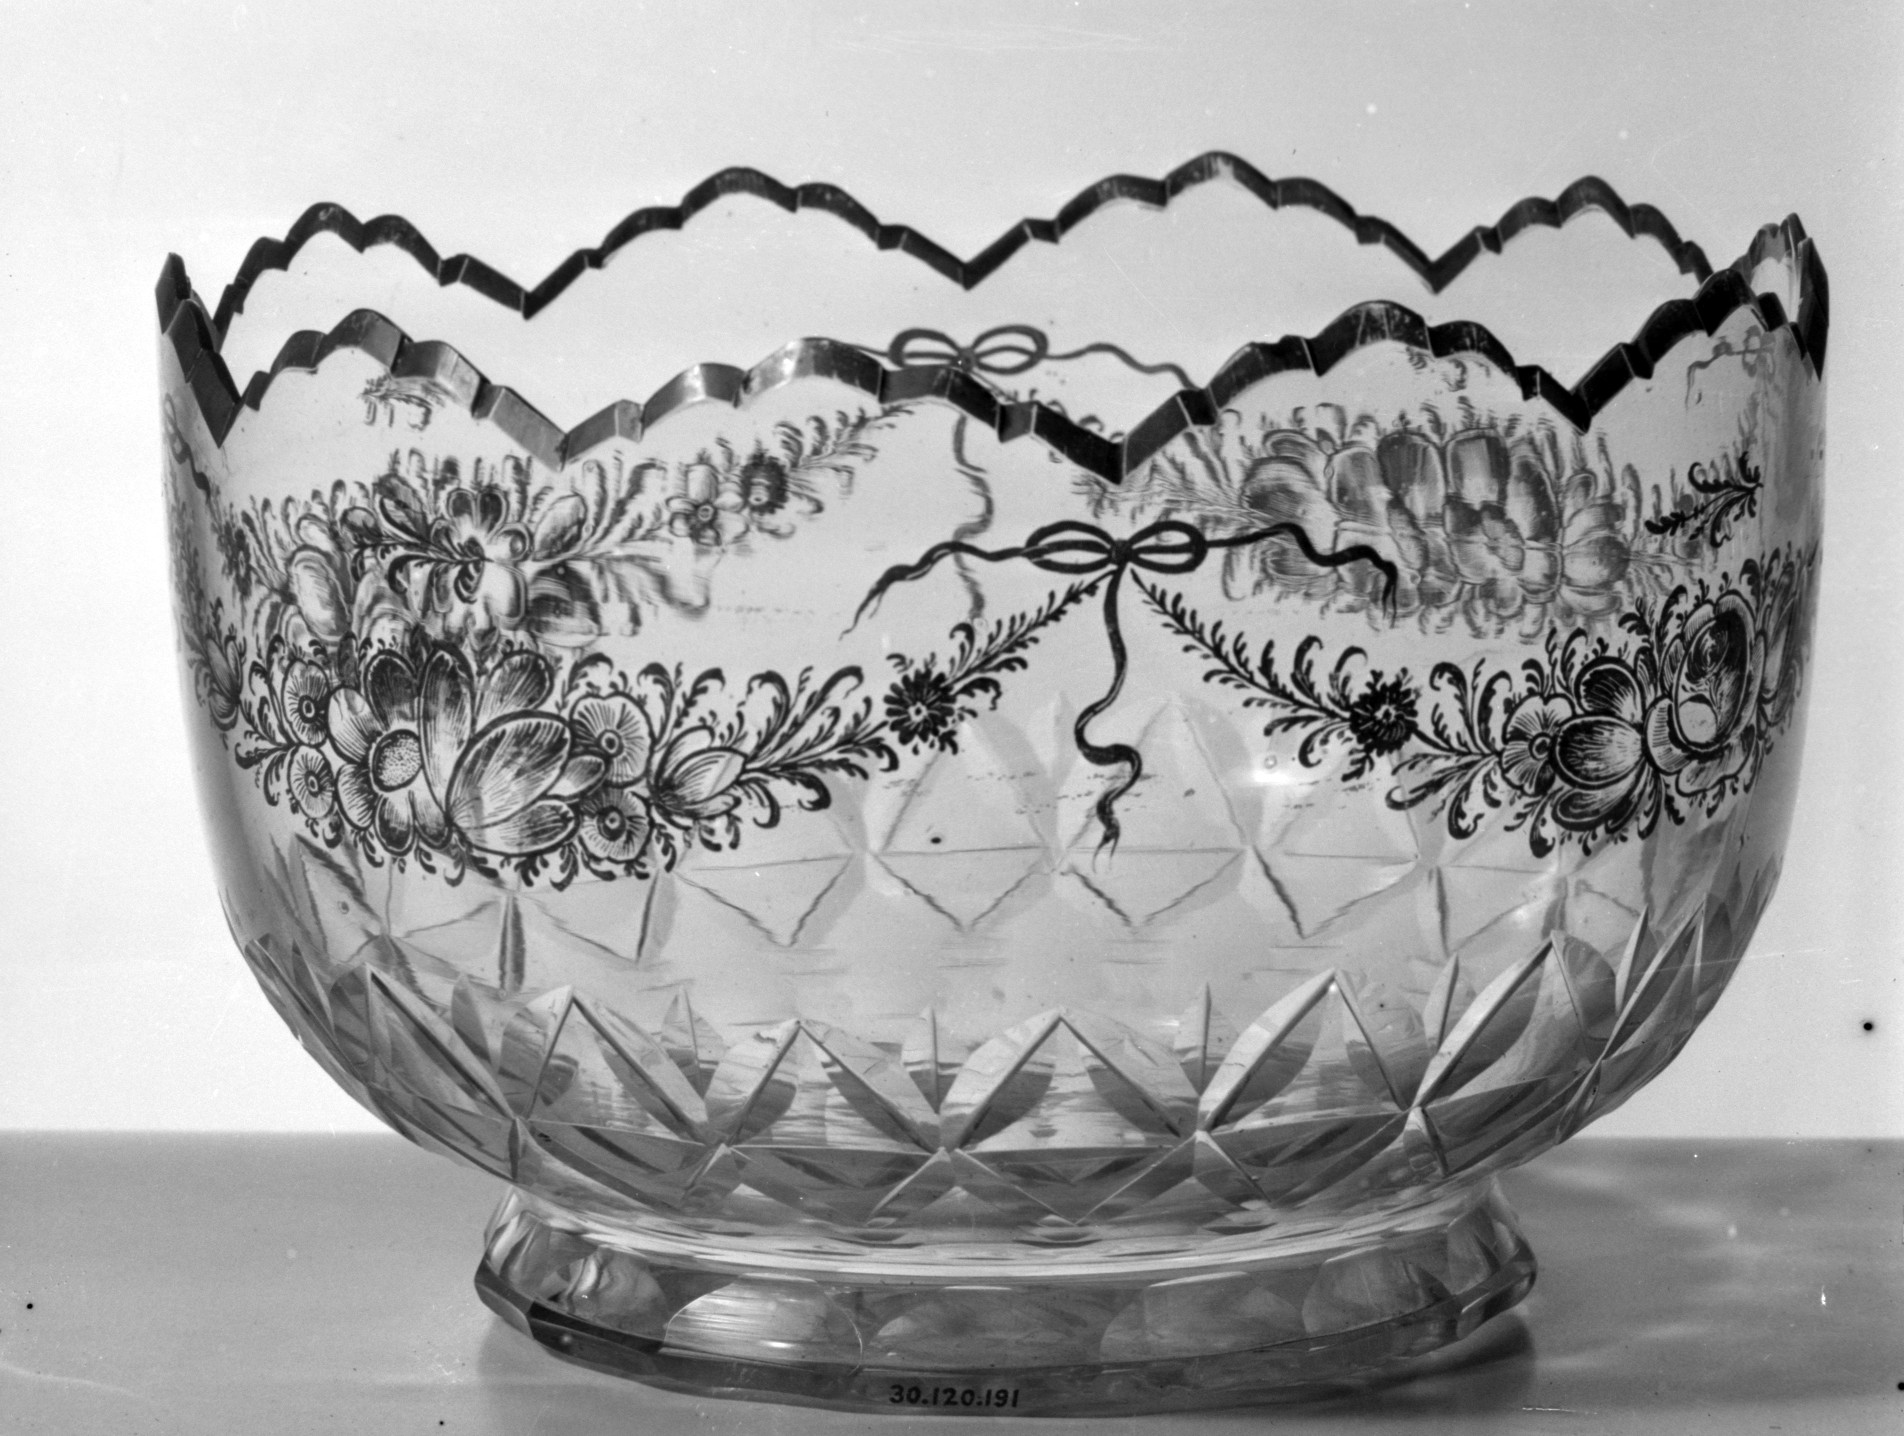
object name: bowl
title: Bowl (one of a pair)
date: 1801-1833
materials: glass